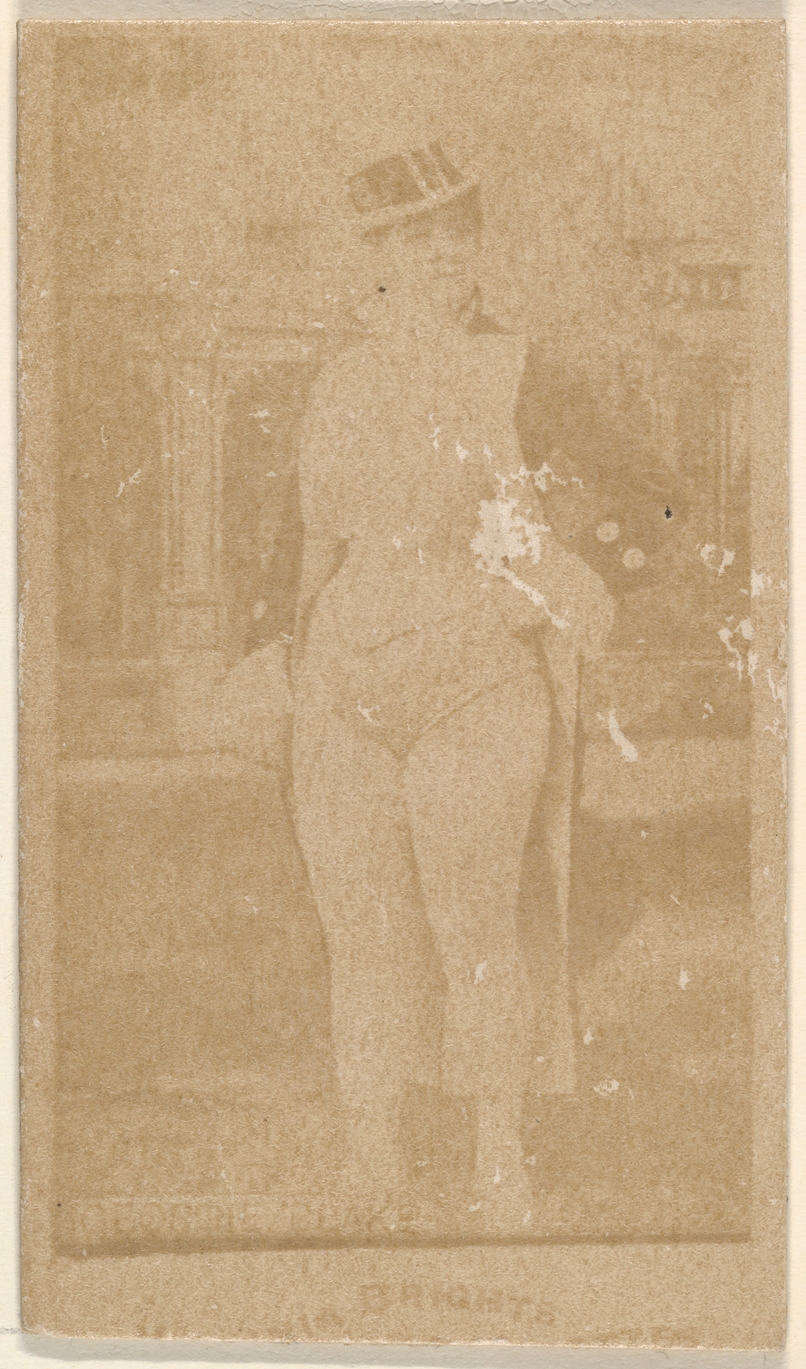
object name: photograph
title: Georgie Blake, From the Actors and Actresses series (N45, Type 1) for Virginia Brights Cigarettes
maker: allen & ginter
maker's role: publisher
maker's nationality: american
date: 1888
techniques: albumen silver print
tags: portraits,women,actresses